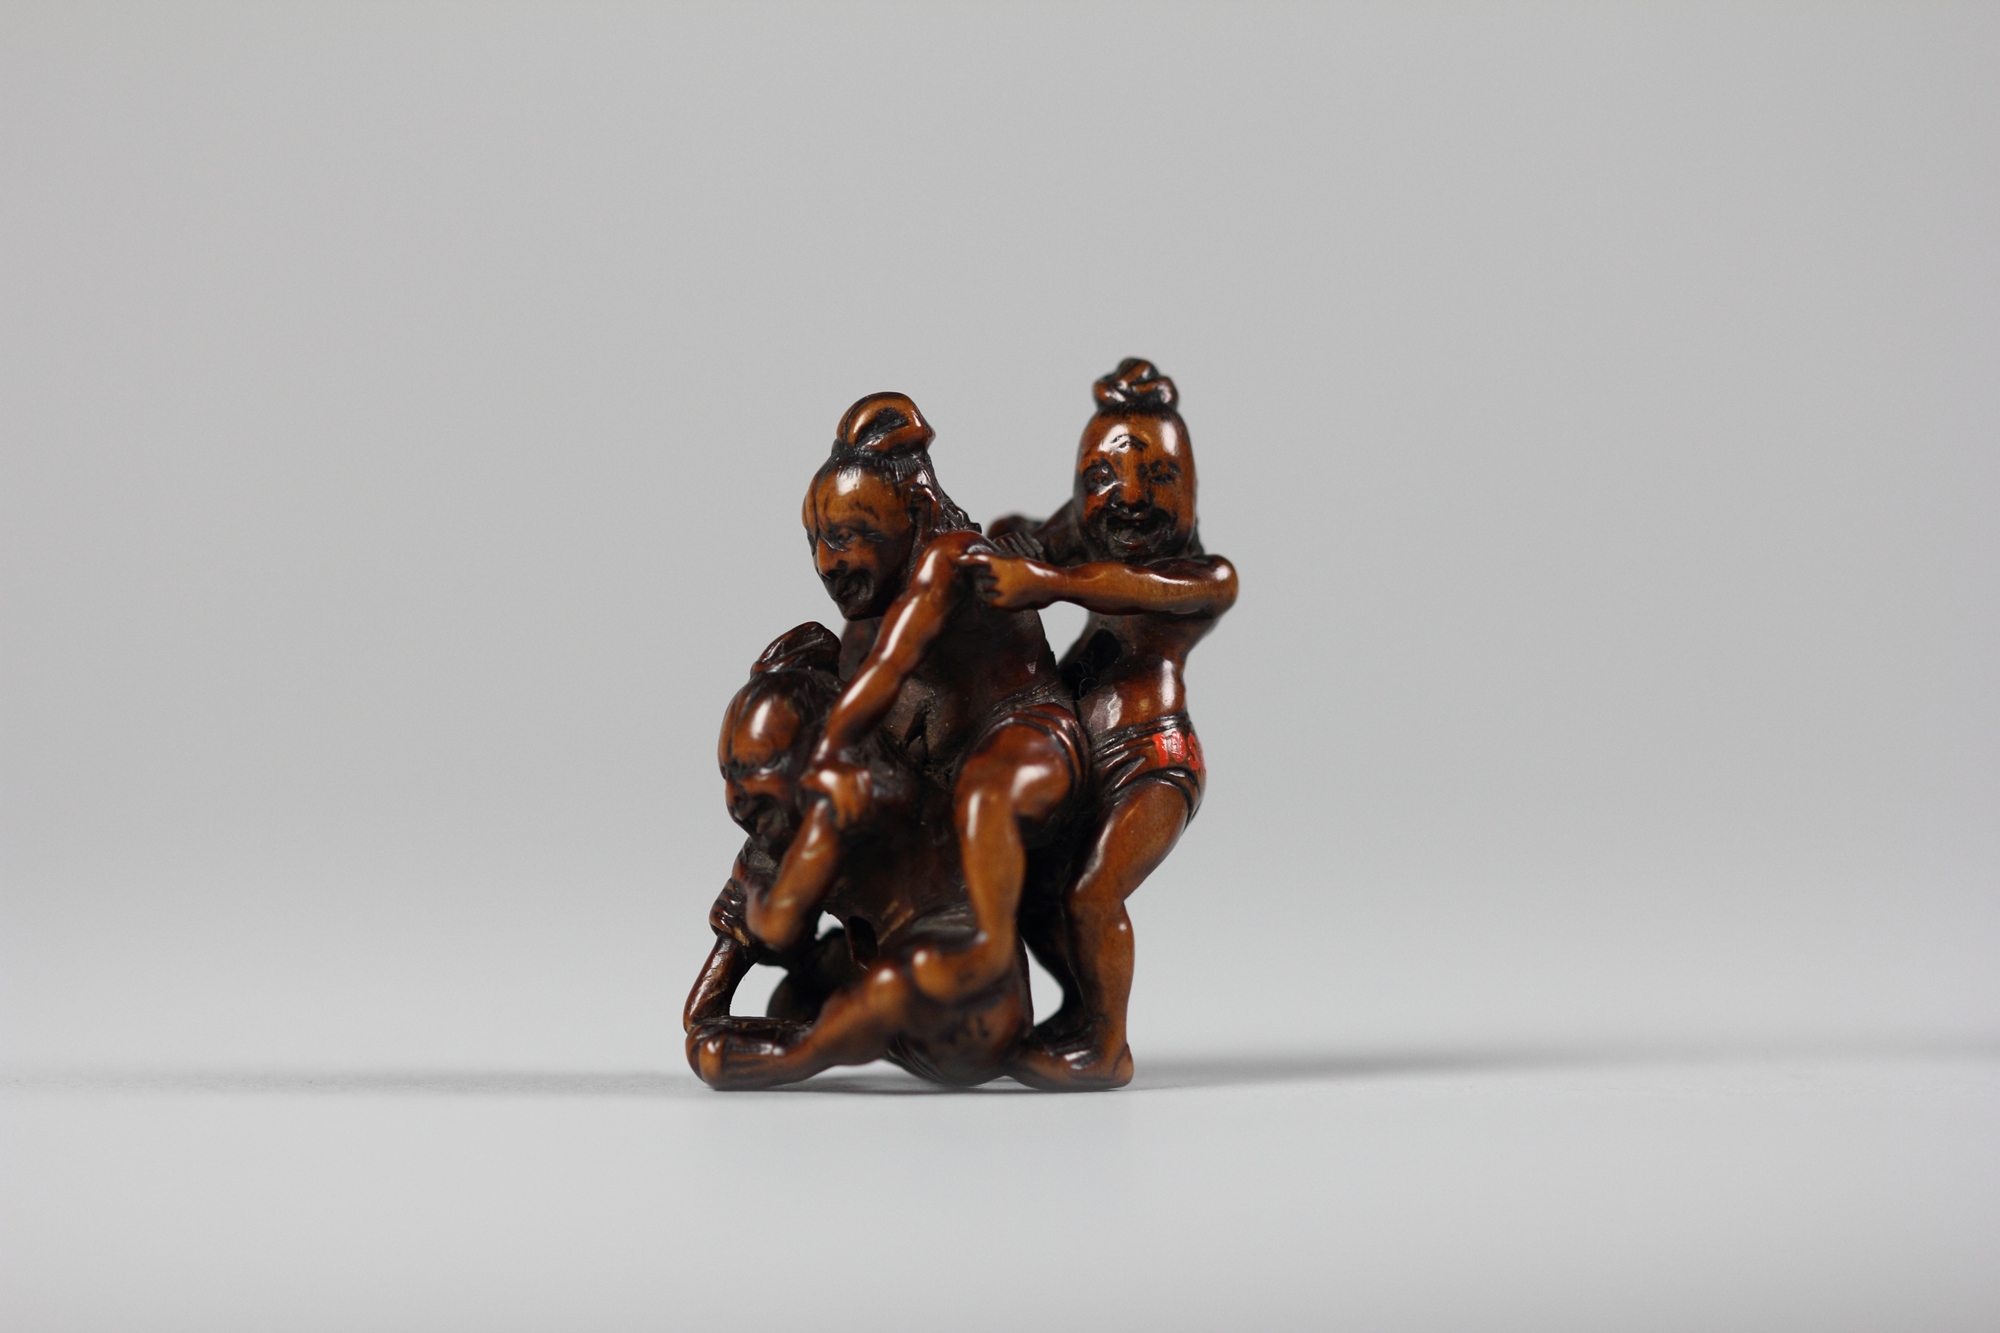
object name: netsuke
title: Netsuke of Group of Figures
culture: japanese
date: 1801-1900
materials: wood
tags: men